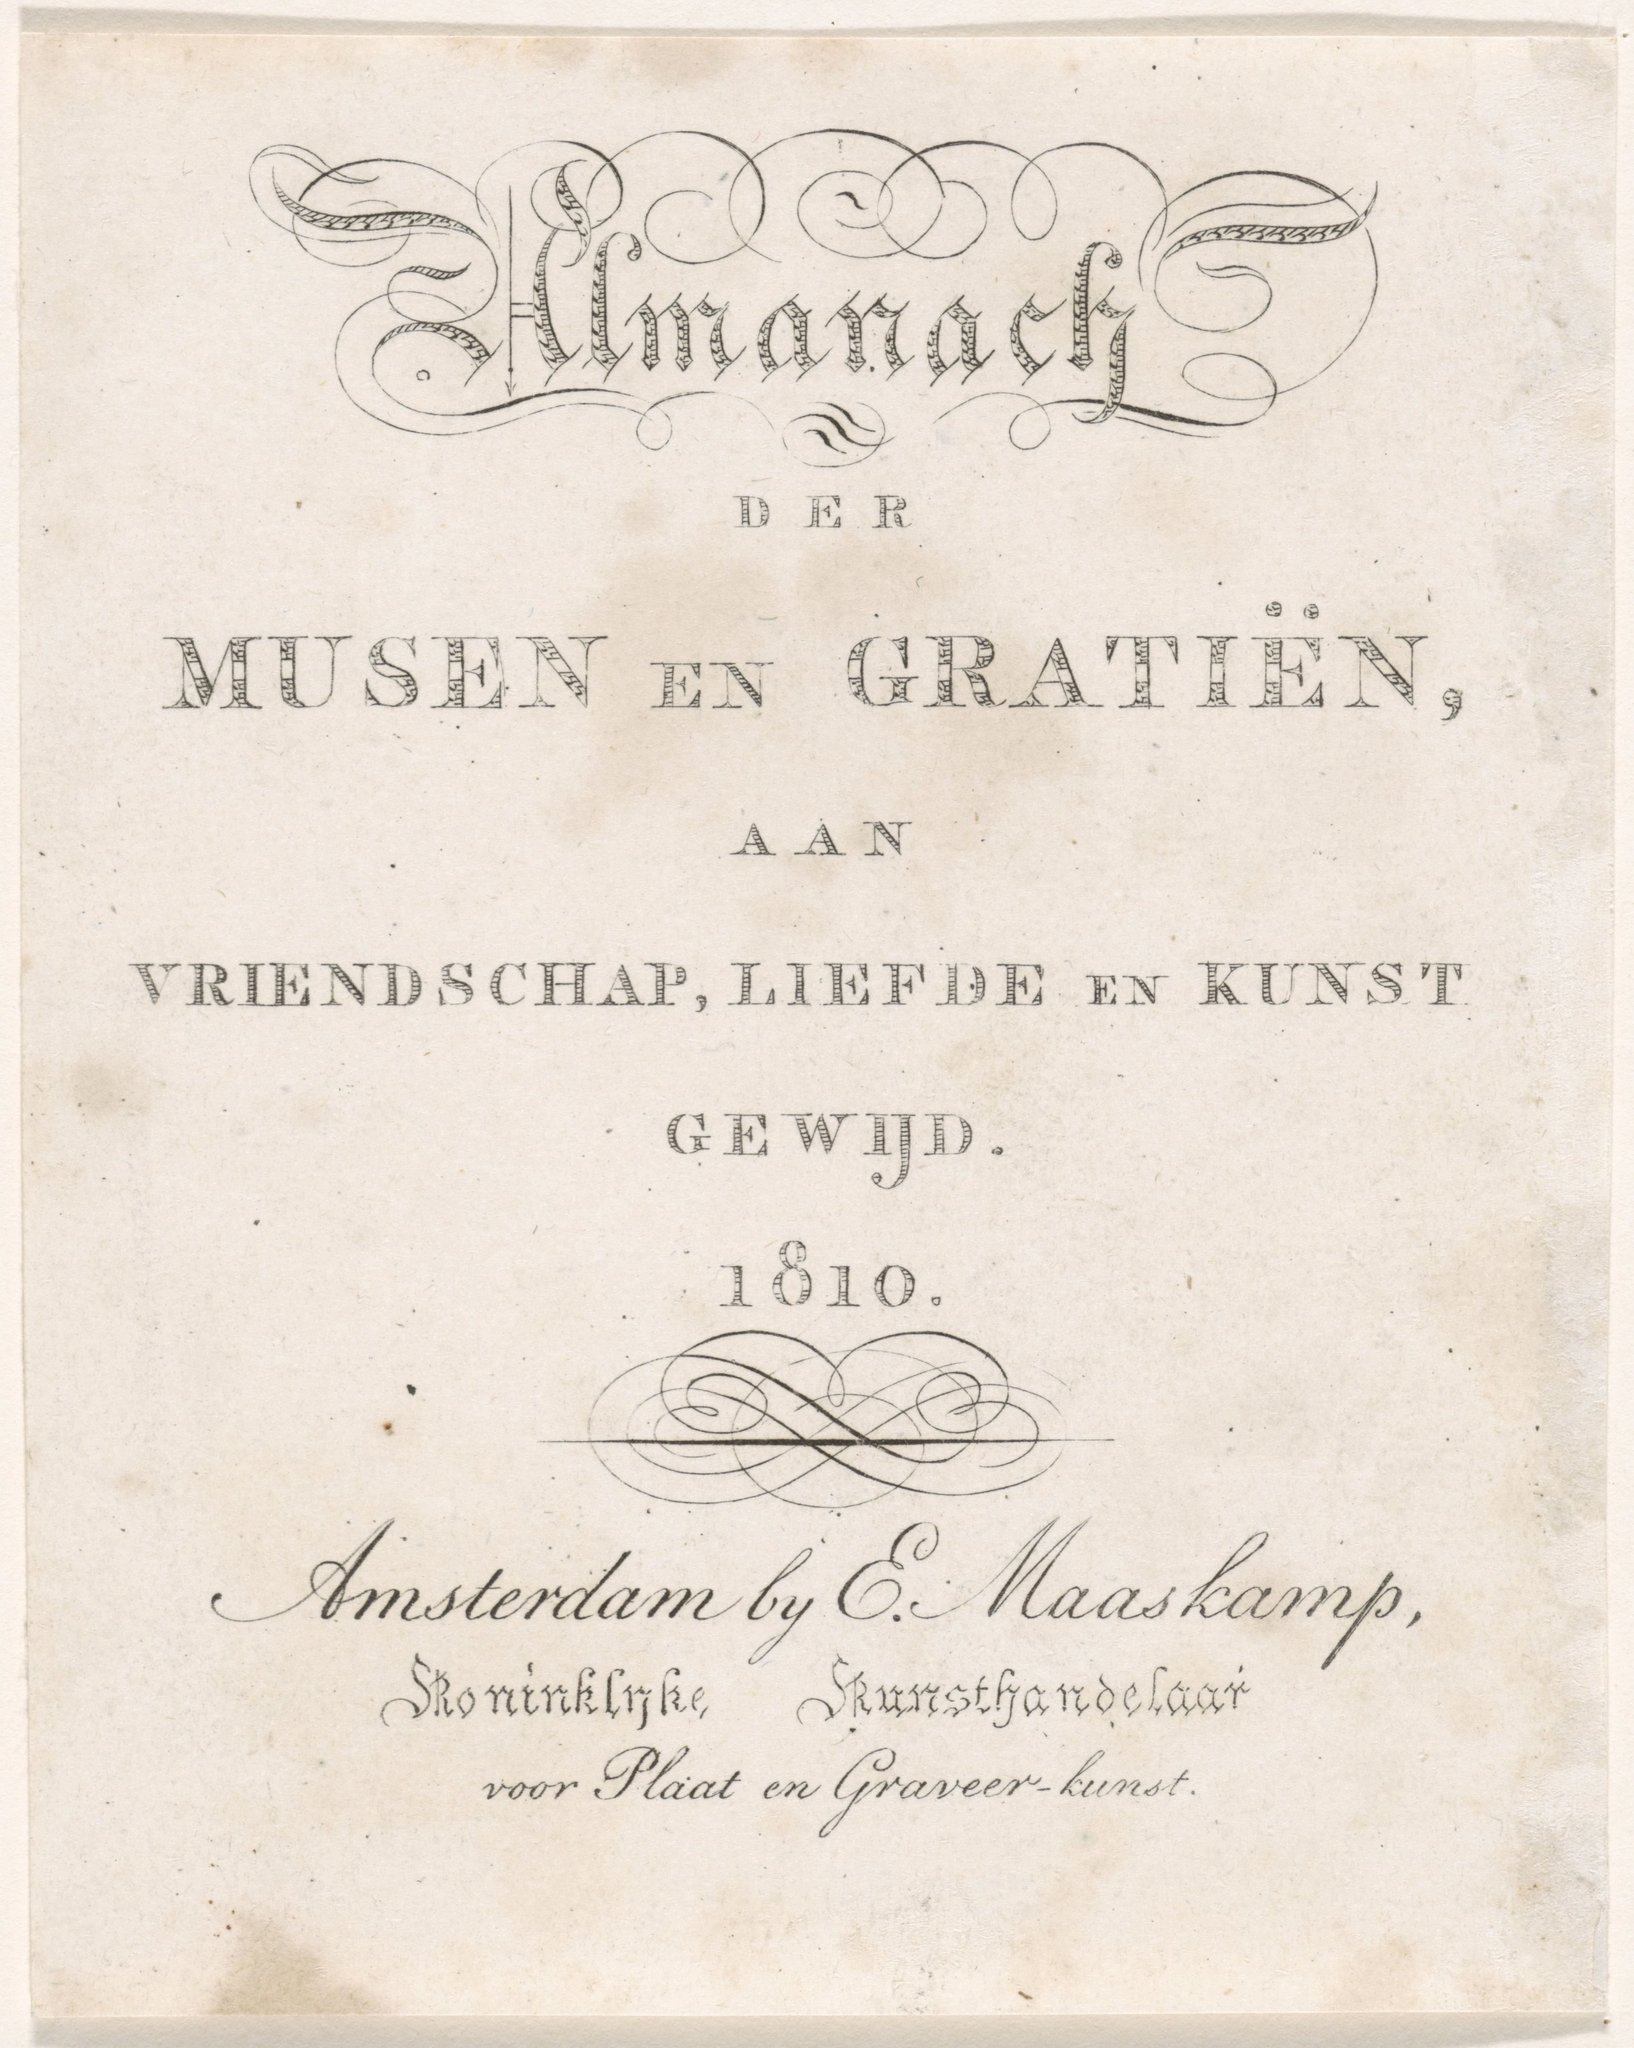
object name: text sheet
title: Titelpagina voor: Almanack der Musen en Gratiën, aan vriendschap, liefde en kunst gewijd, 1810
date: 1810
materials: paper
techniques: etching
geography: amsterdam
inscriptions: collector's mark: Lugt 2228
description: Titelpagina voor: Almanak der Musen en Gratiën, aan Vriendschap, Liefde en Kunst gewijd. Amsterdam: Evert Maaskamp, 1810.